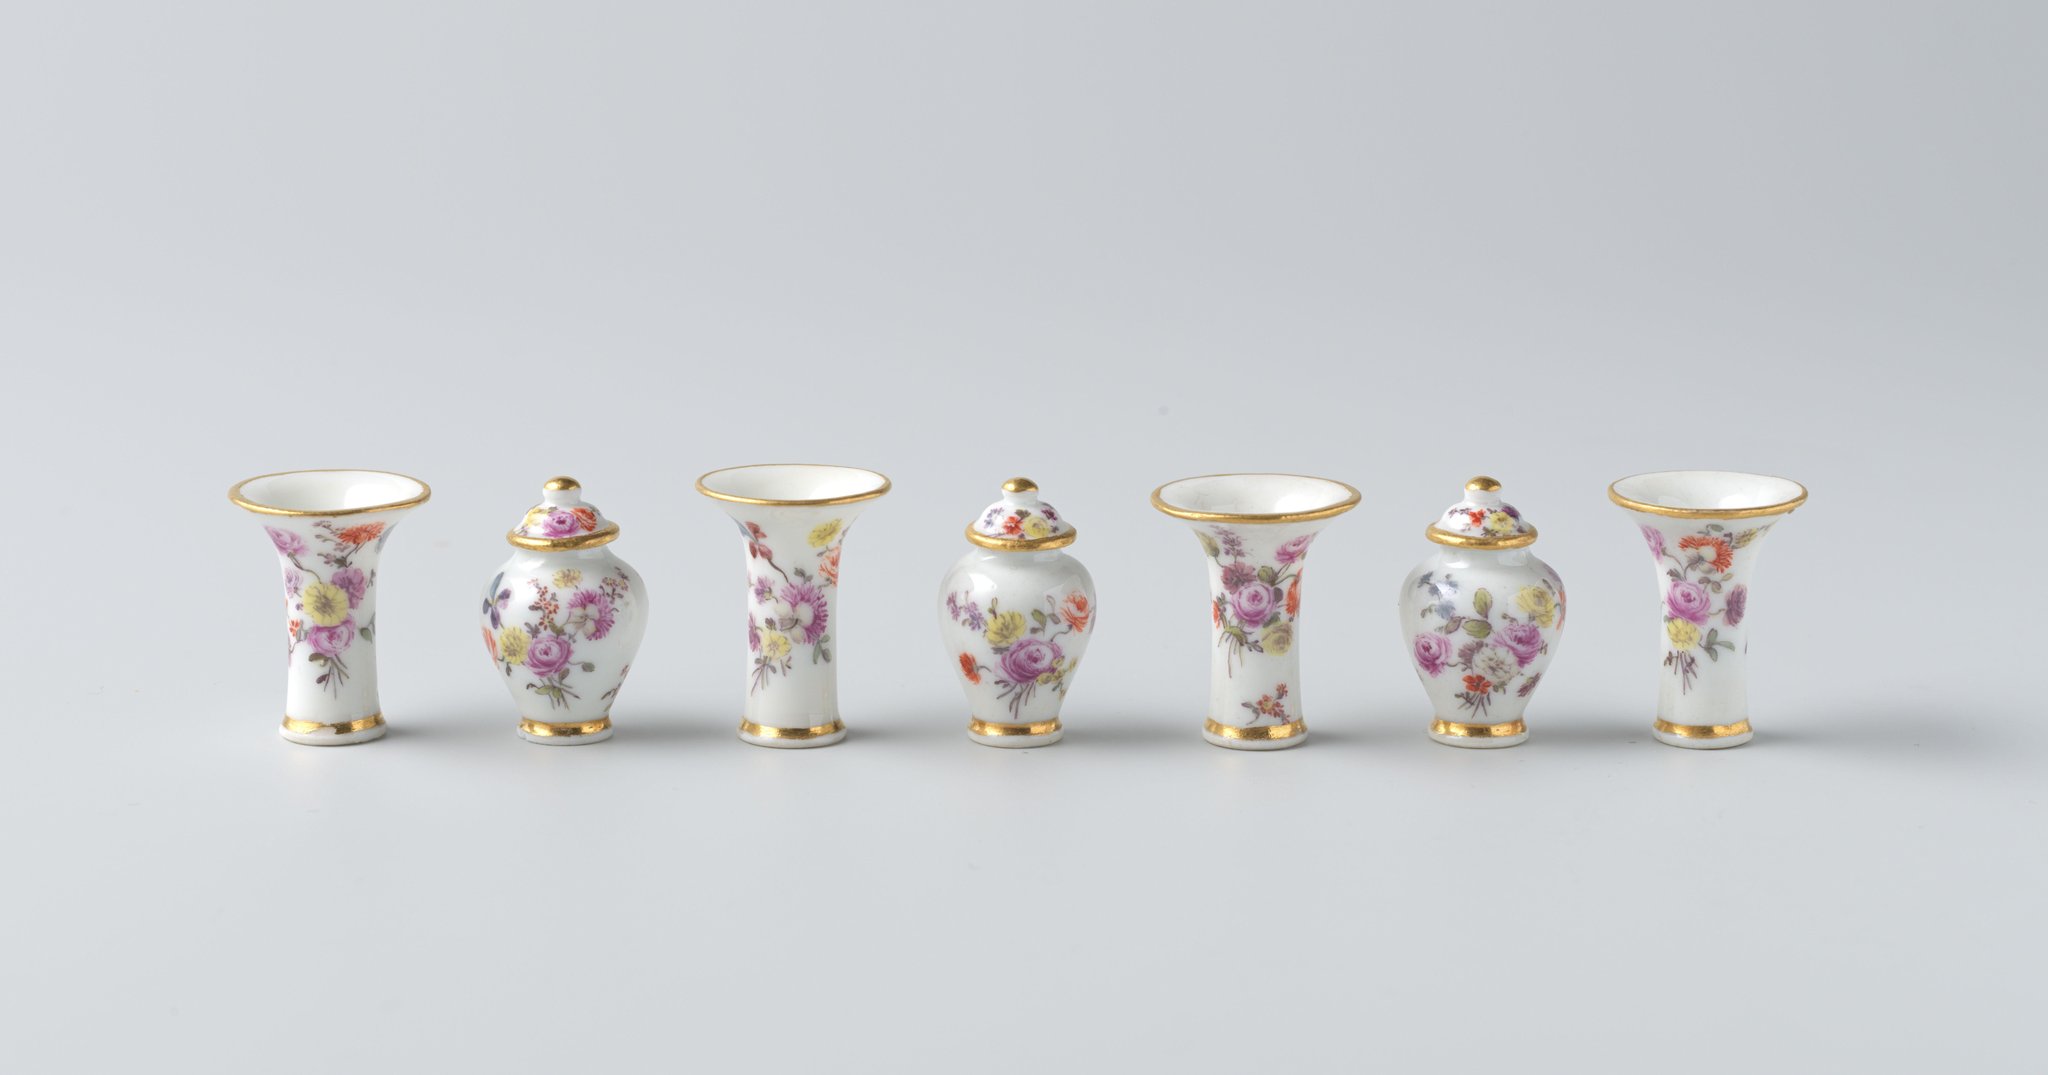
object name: miniature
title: Zevendelig kaststel, beschilderd met bloemboeketten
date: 1750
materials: porcelain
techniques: painted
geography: meissen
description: Zevendelig kaststel van porselein, bestaande uit drie dekselpotten en vier vazen met wijduitstaande mondrand. Het stel is beschilderd met veelkleurige bloemboeketten, de knoppen op de deksels en de voet- en de mondranden zijn verguld. Eén pot en één vaas zijn gemerkt.